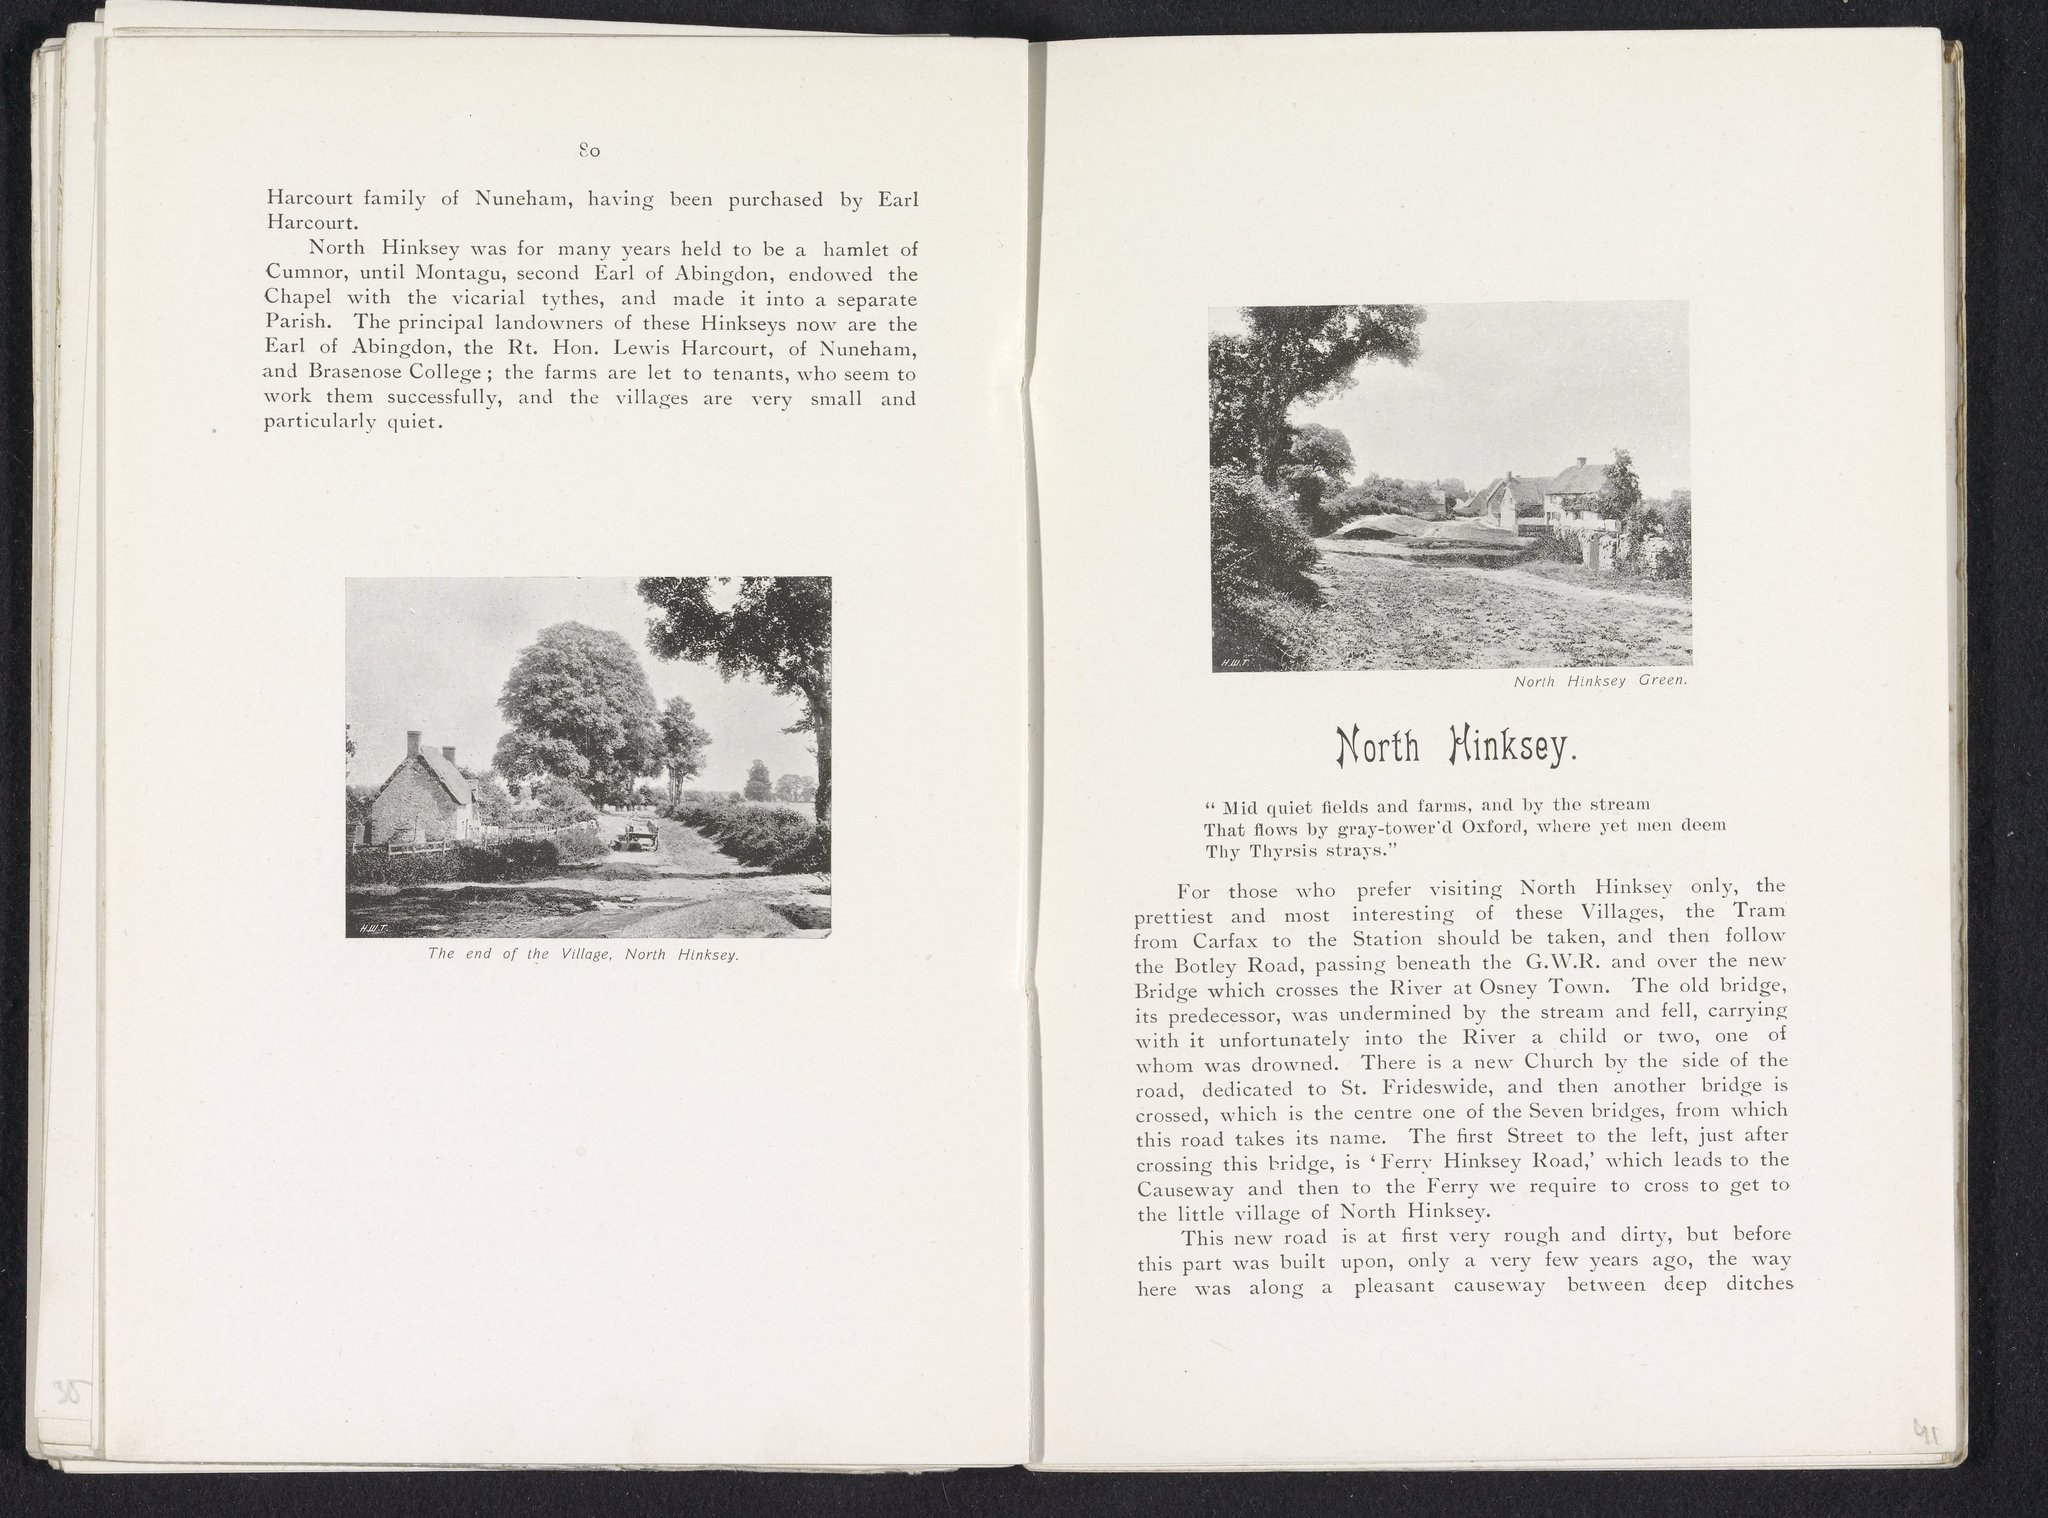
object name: page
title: The end of the village, North Hinksey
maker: henry w. taunt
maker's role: fotograaf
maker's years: 1842-1922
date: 1907-1912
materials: paper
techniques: autotype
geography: north hinksey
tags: public road in village